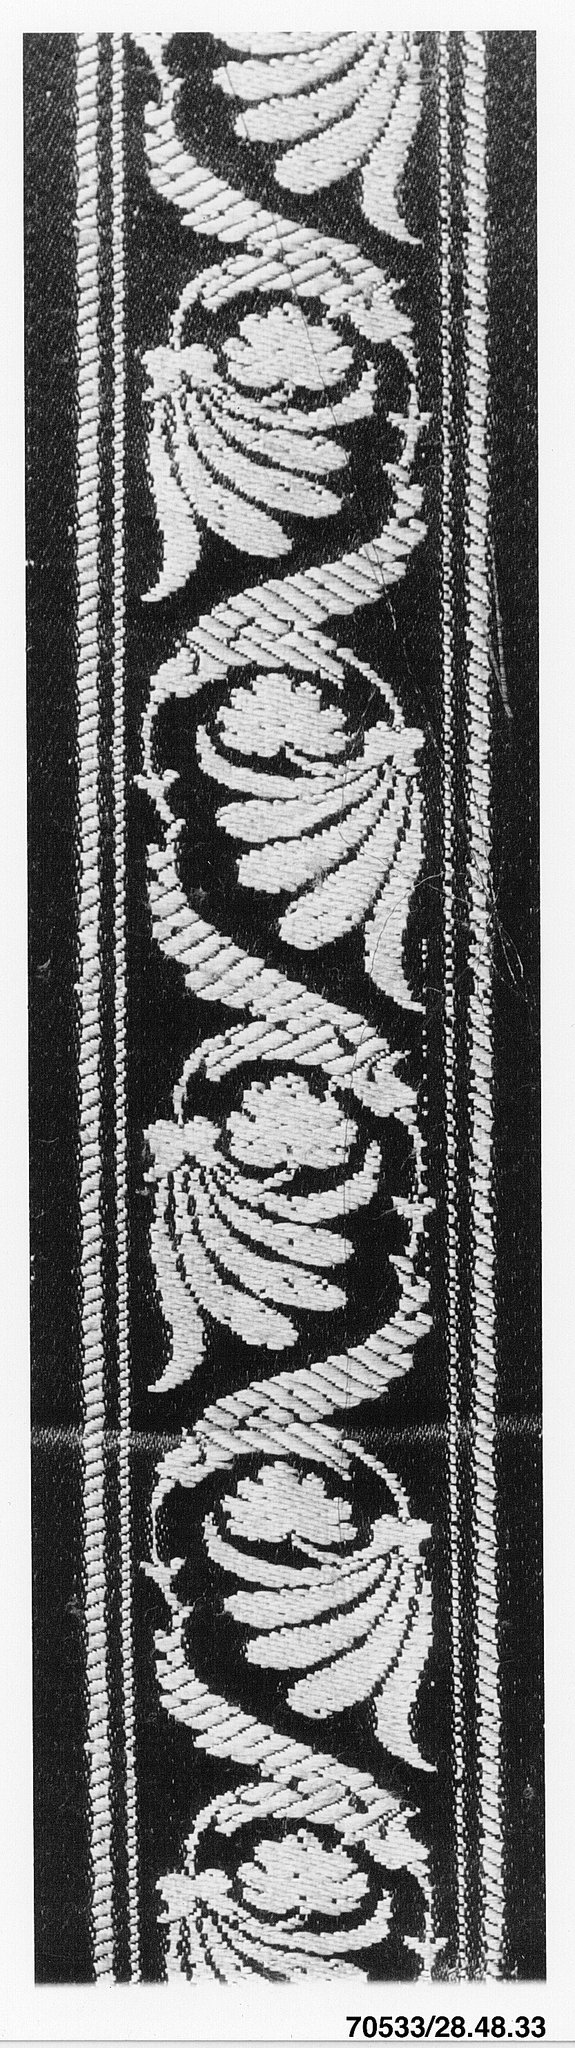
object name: border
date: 1801-1900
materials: silk